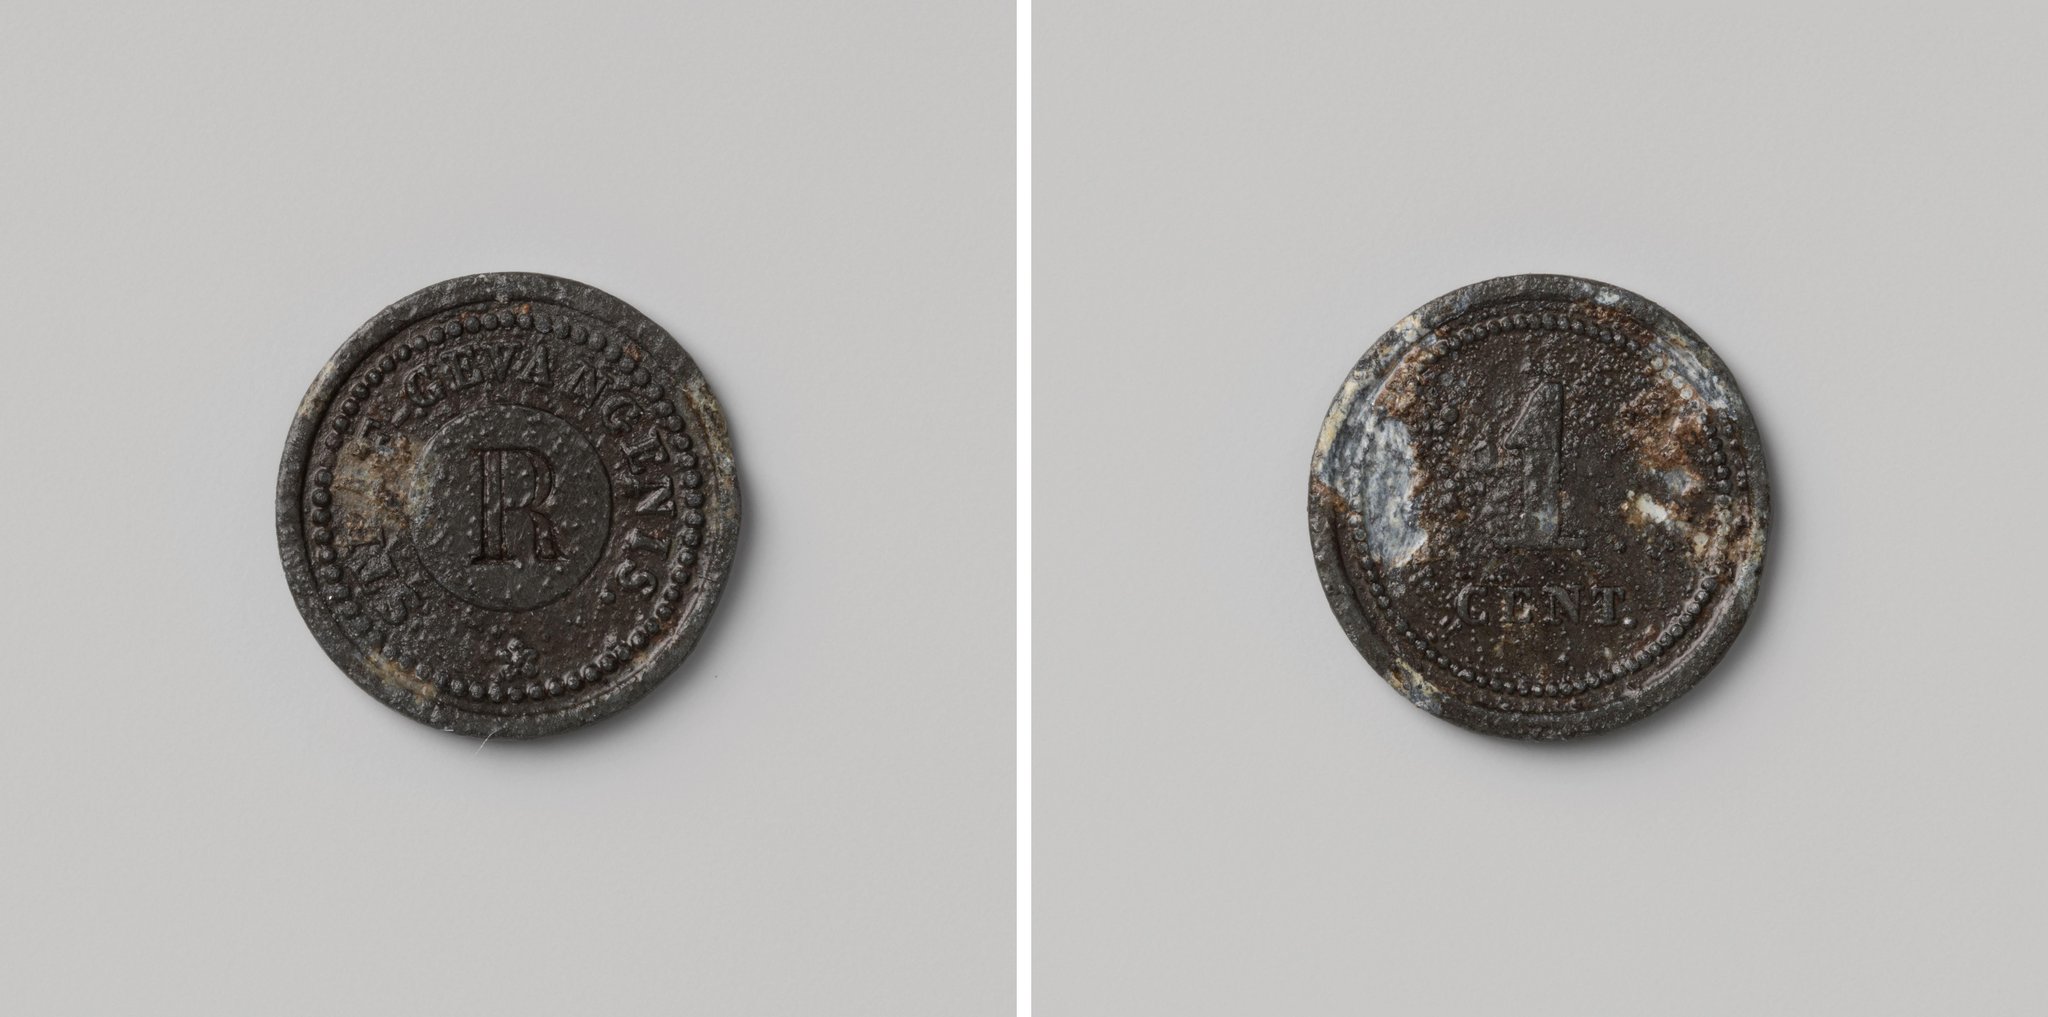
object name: cent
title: Strafgevangenis te Rotterdam, huismunt ter waarde van een cent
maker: Anonymous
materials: zinc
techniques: striking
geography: utrecht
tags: rotterdam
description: Zinken betaalpenning. Voorzijde: letter R binnen omschrift. Keerzijde: waardeaanduiding